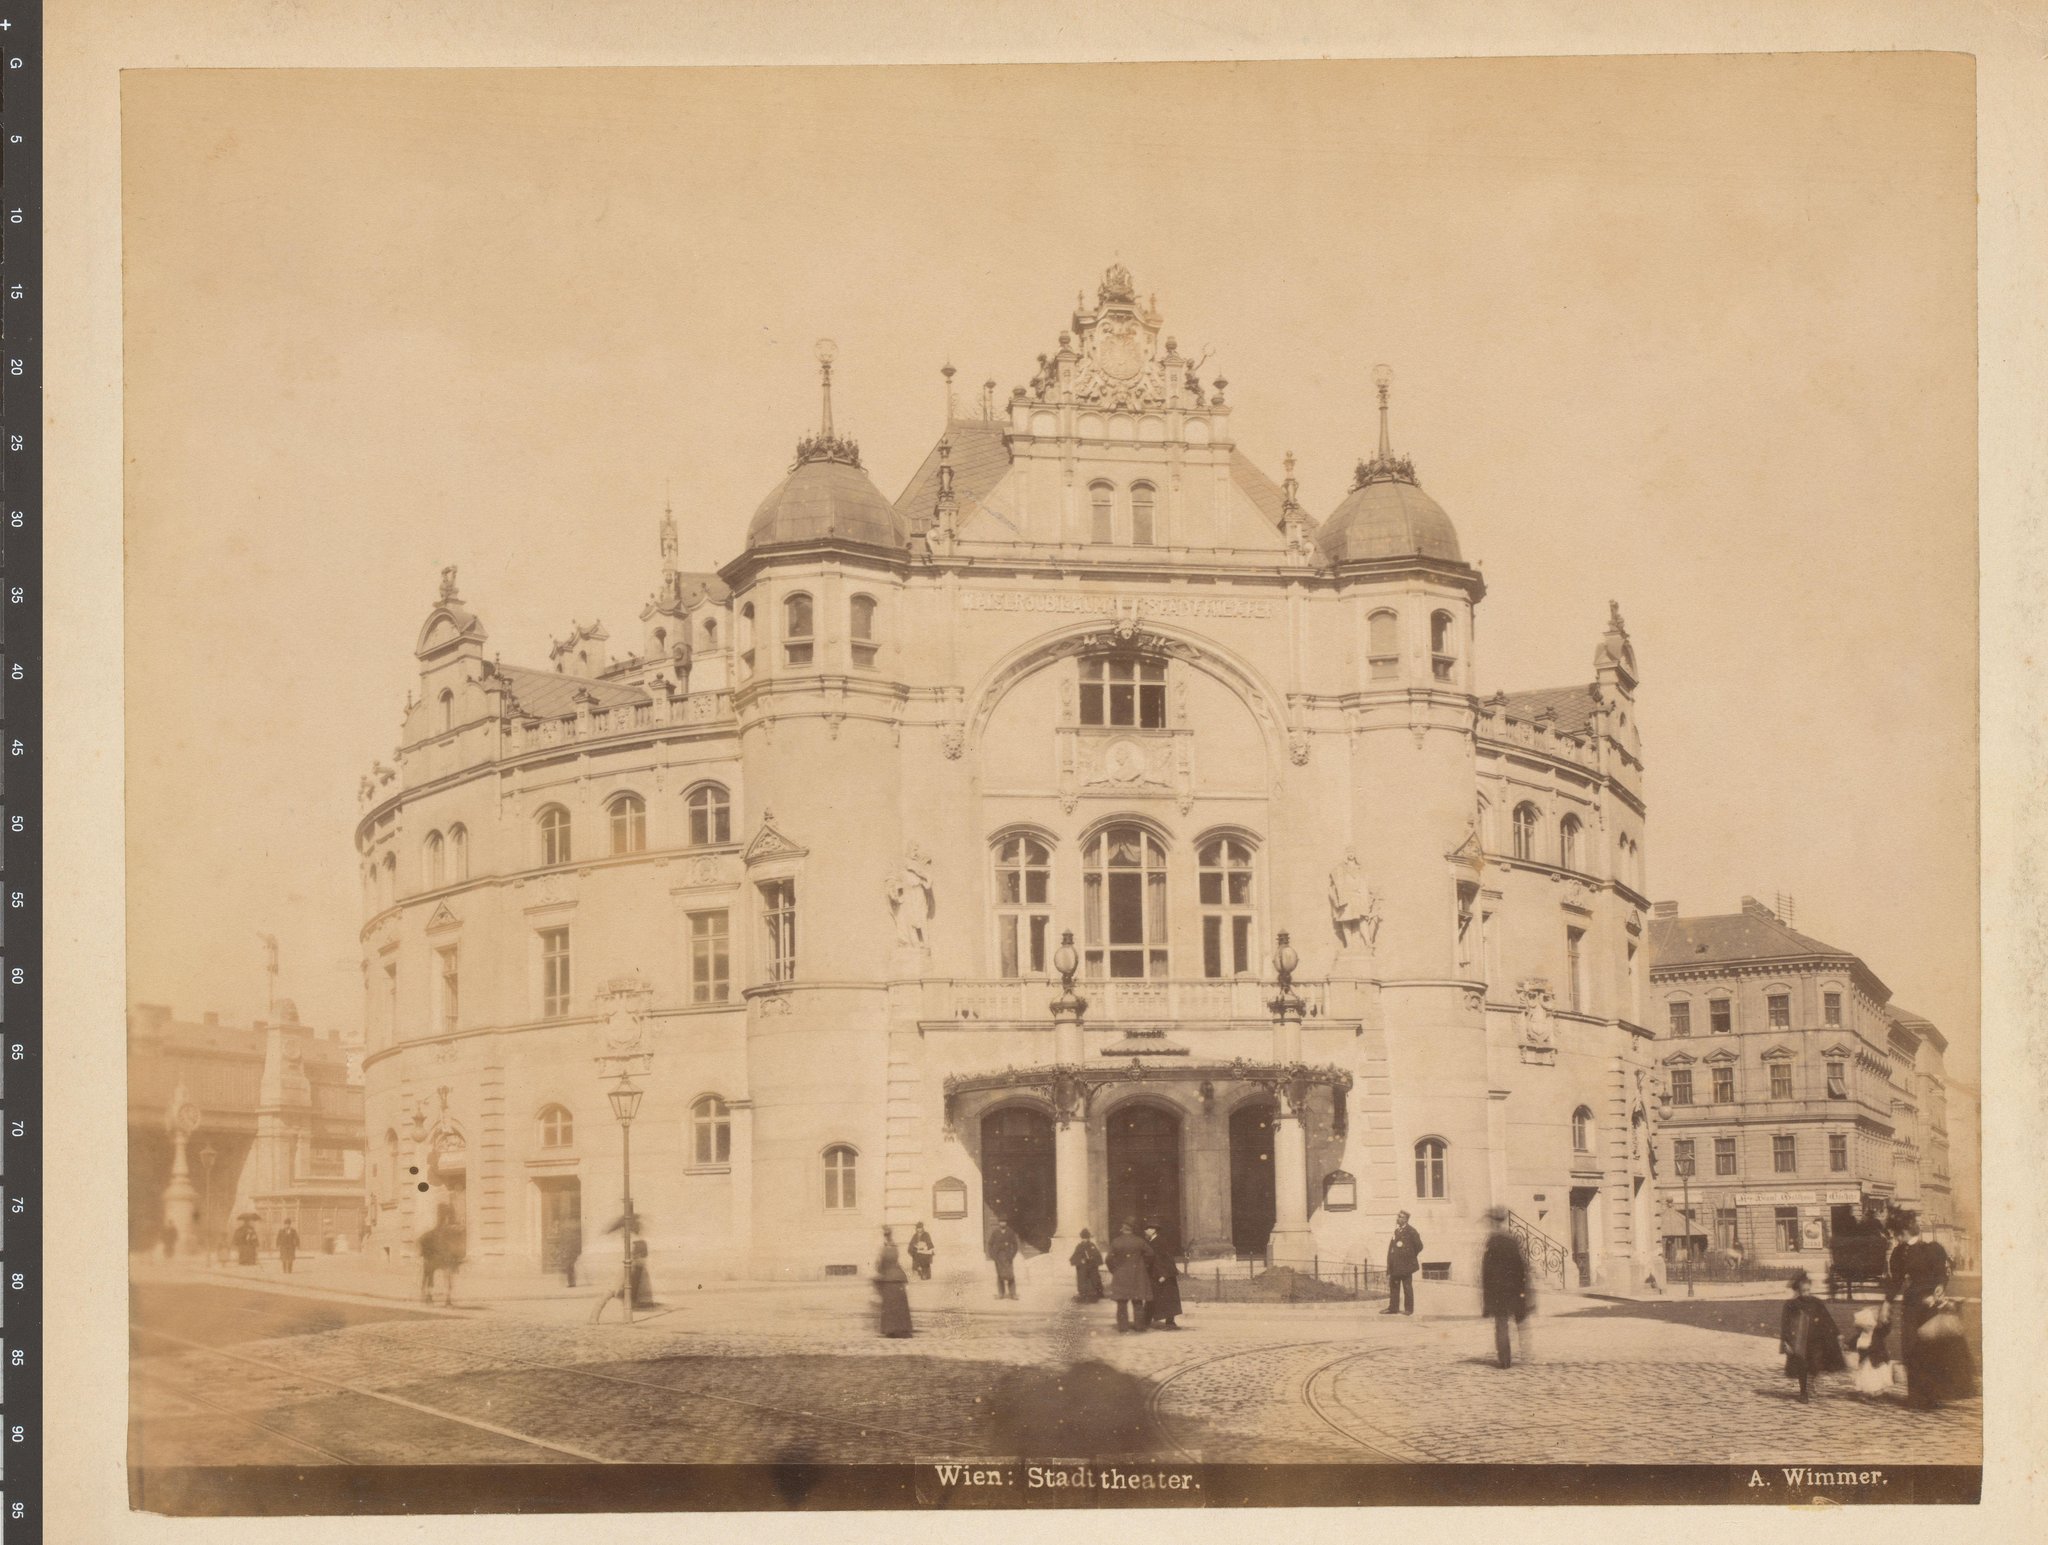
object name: photograph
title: Stadttheater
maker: a. wimmer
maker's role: fotograaf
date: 1898-1900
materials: cardboard, paper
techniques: albumen print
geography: vienna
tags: opera house